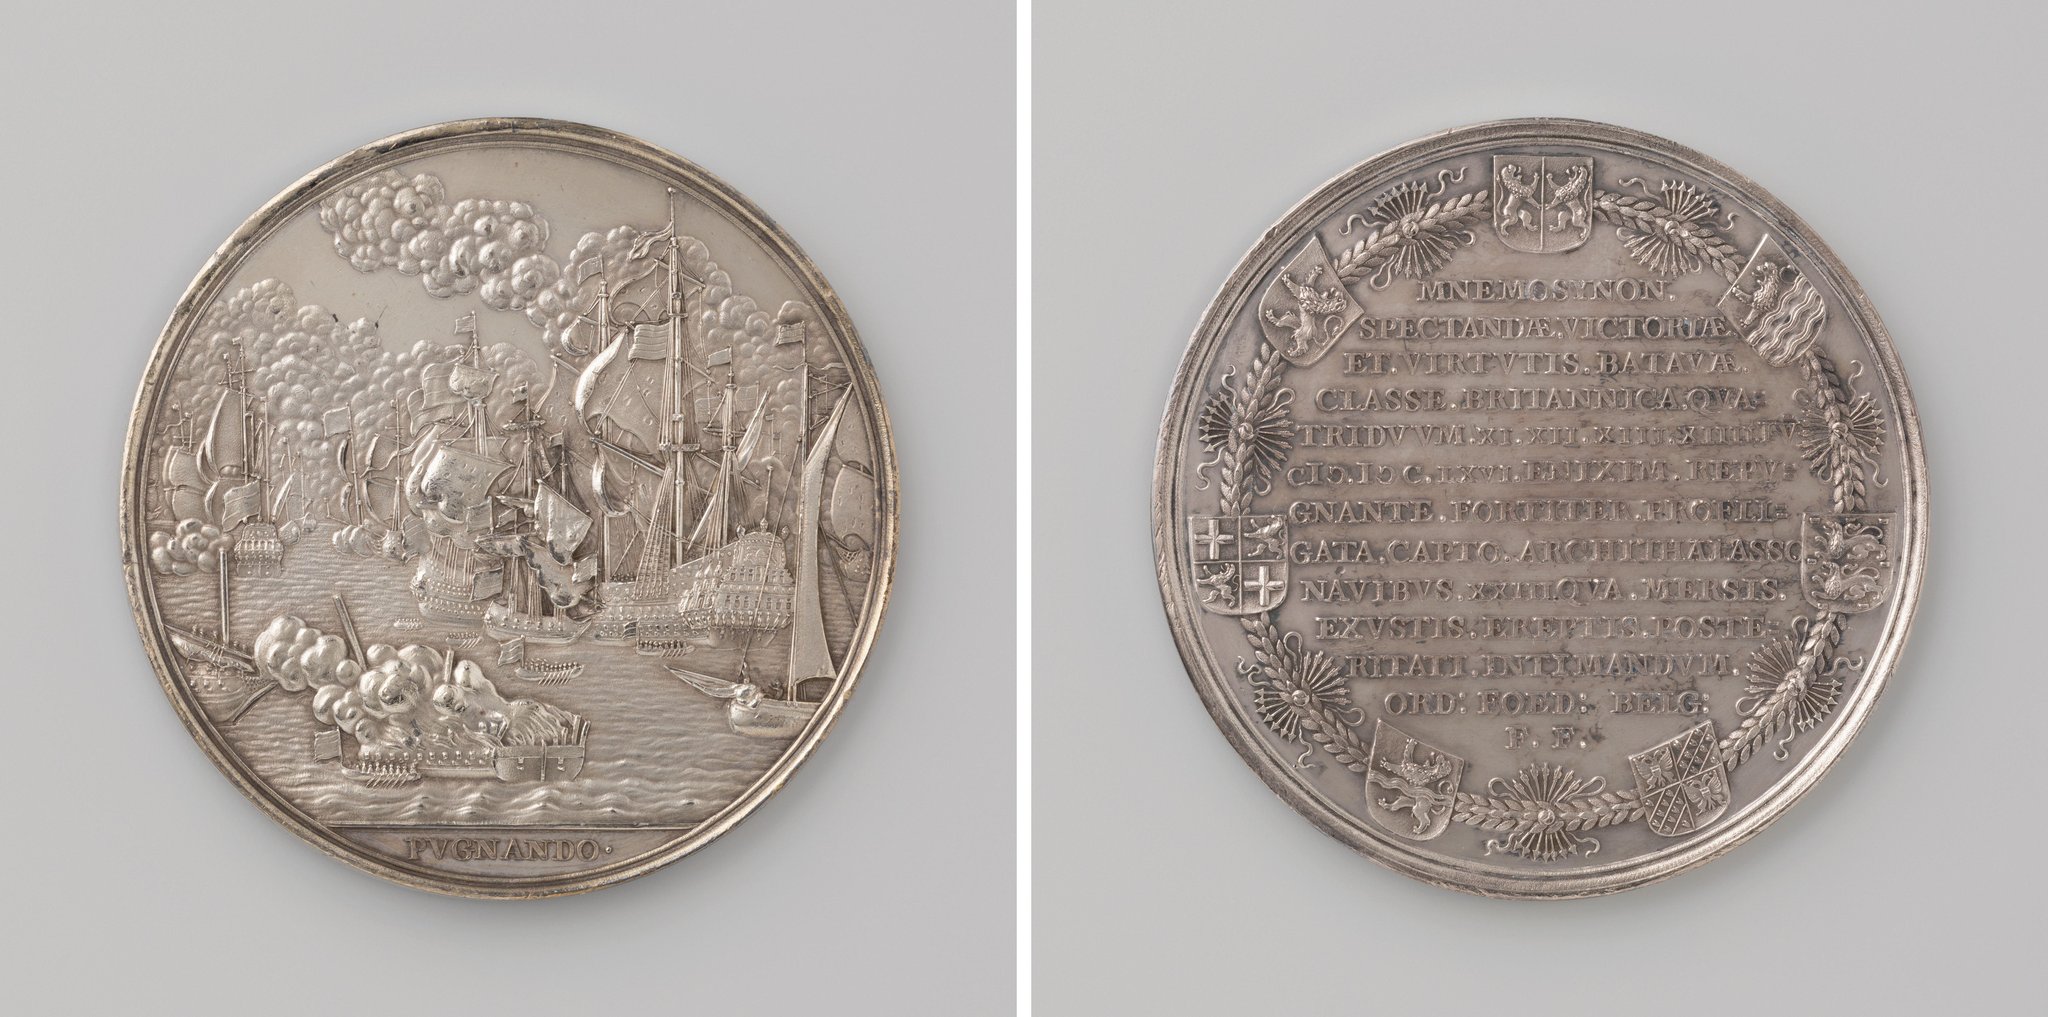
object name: history medal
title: Vierdaagse zeeslag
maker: christoffel adolphi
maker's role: medailleur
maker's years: 1630-1684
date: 1666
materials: silver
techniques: striking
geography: enkhuizen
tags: staten-generaal, north foreland, kent, vierdaagse zeeslag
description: Zilveren penning. Voorzijde: zeeslag boven opschrift. Keerzijde: opschrift binnen lauwerkrans met zeven wapenschilden en pijlenbundels.